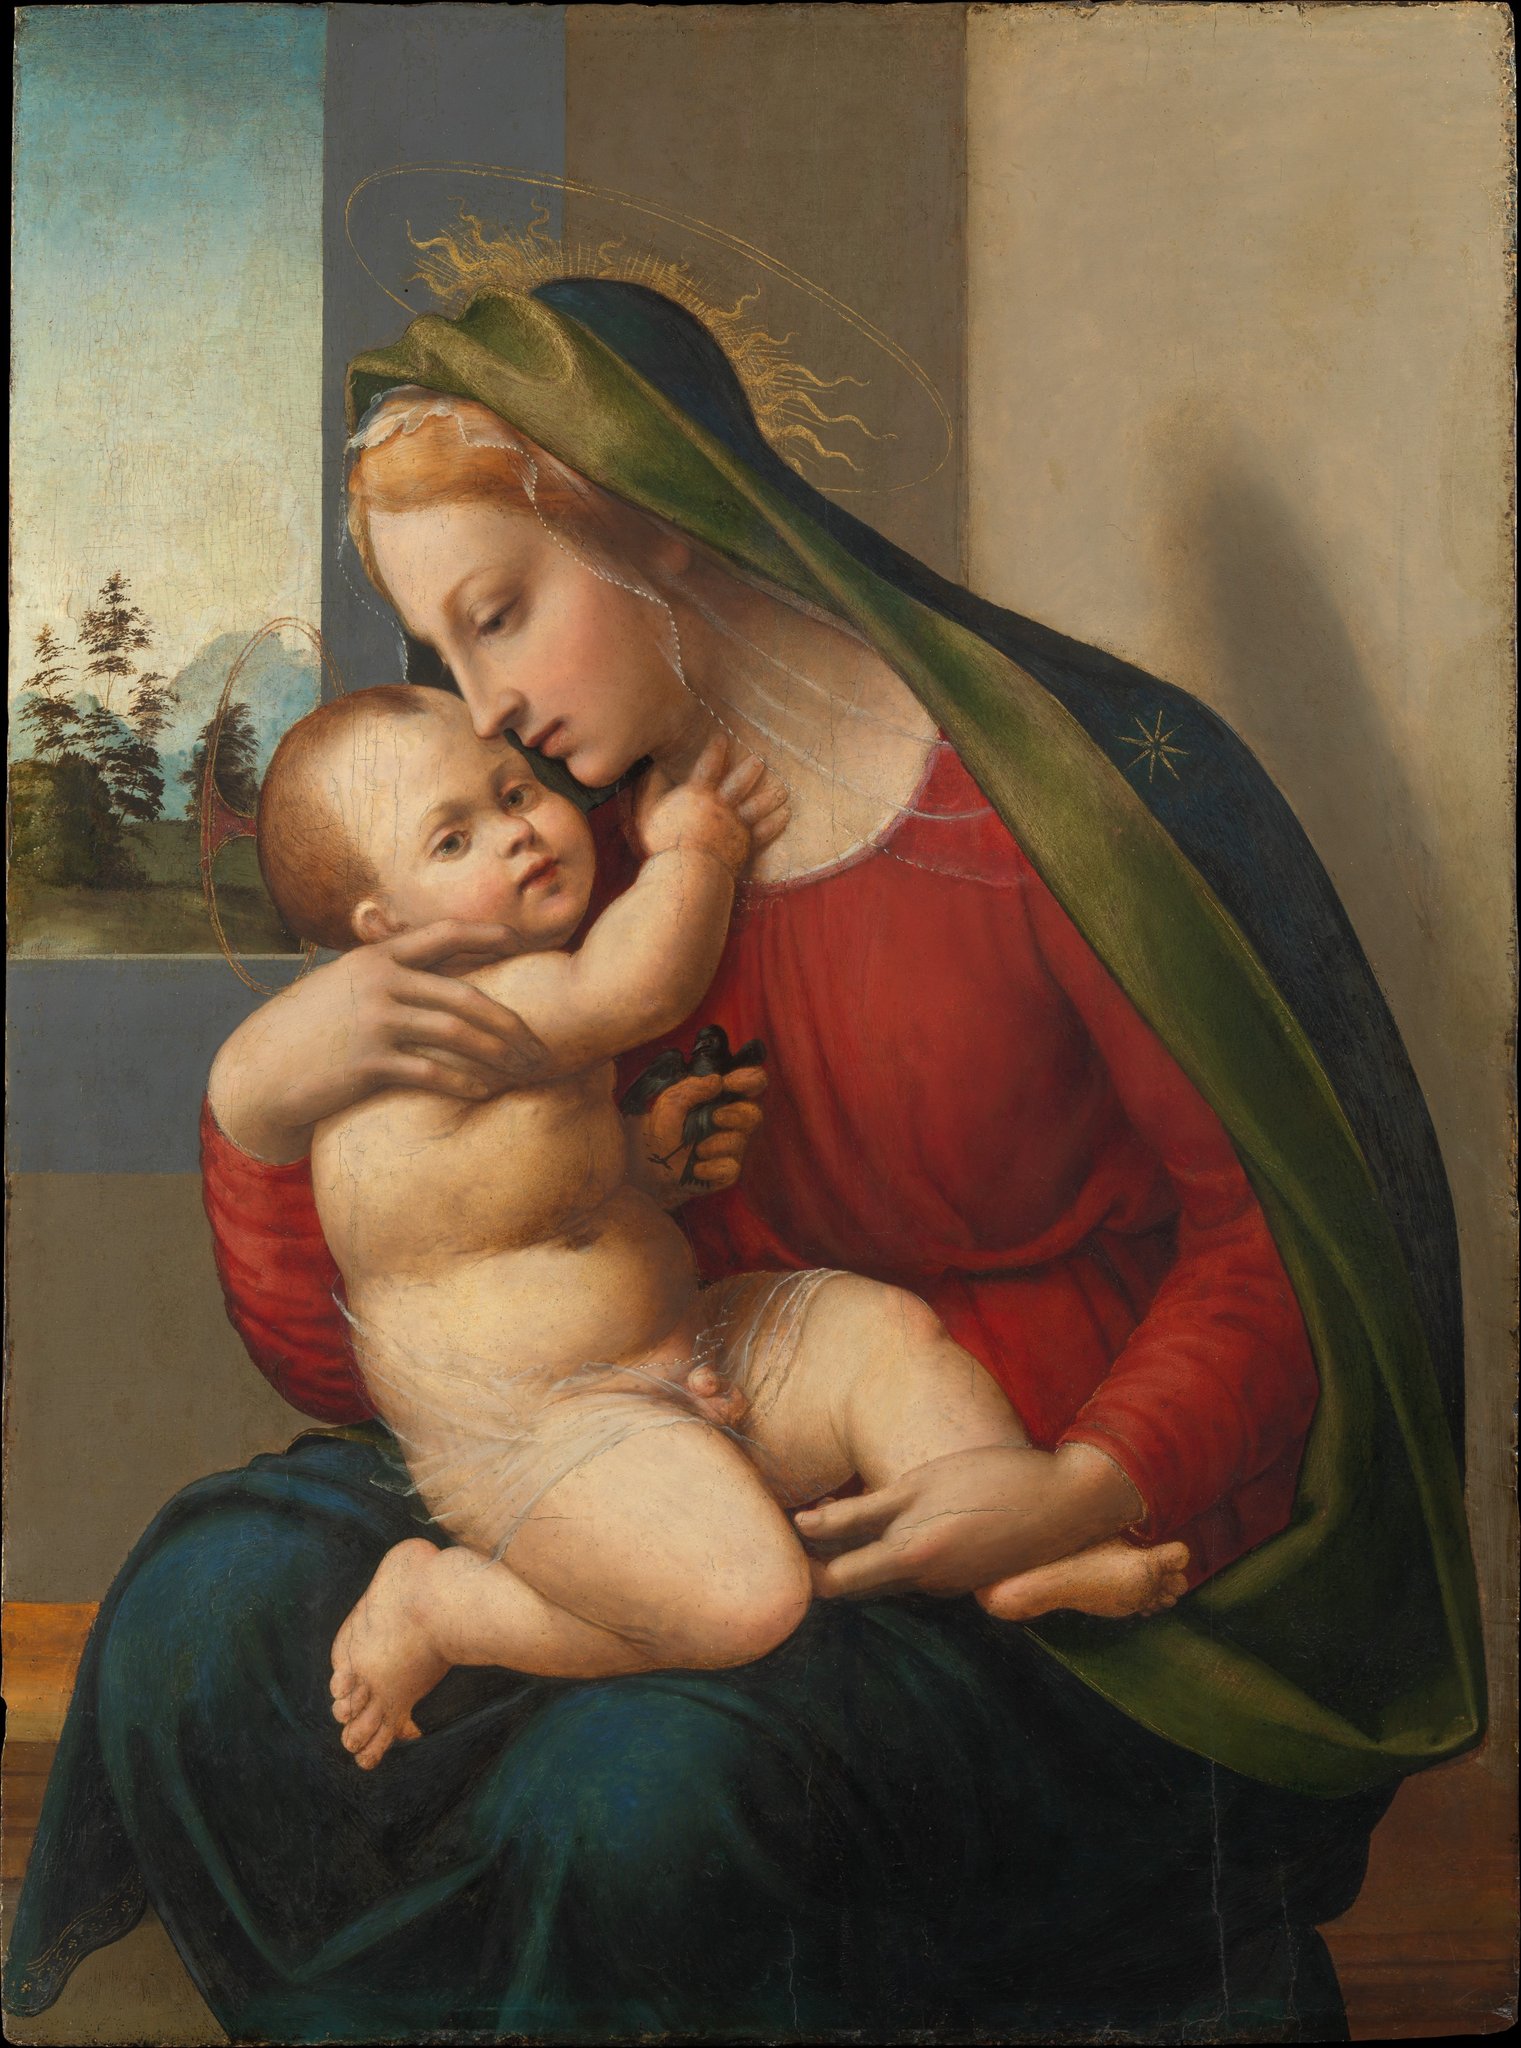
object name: painting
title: Madonna and Child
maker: francesco granacci (francesco di andrea di marco)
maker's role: artist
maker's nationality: italian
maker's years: 1469-1543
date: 1520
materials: oil, wood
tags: madonna and child